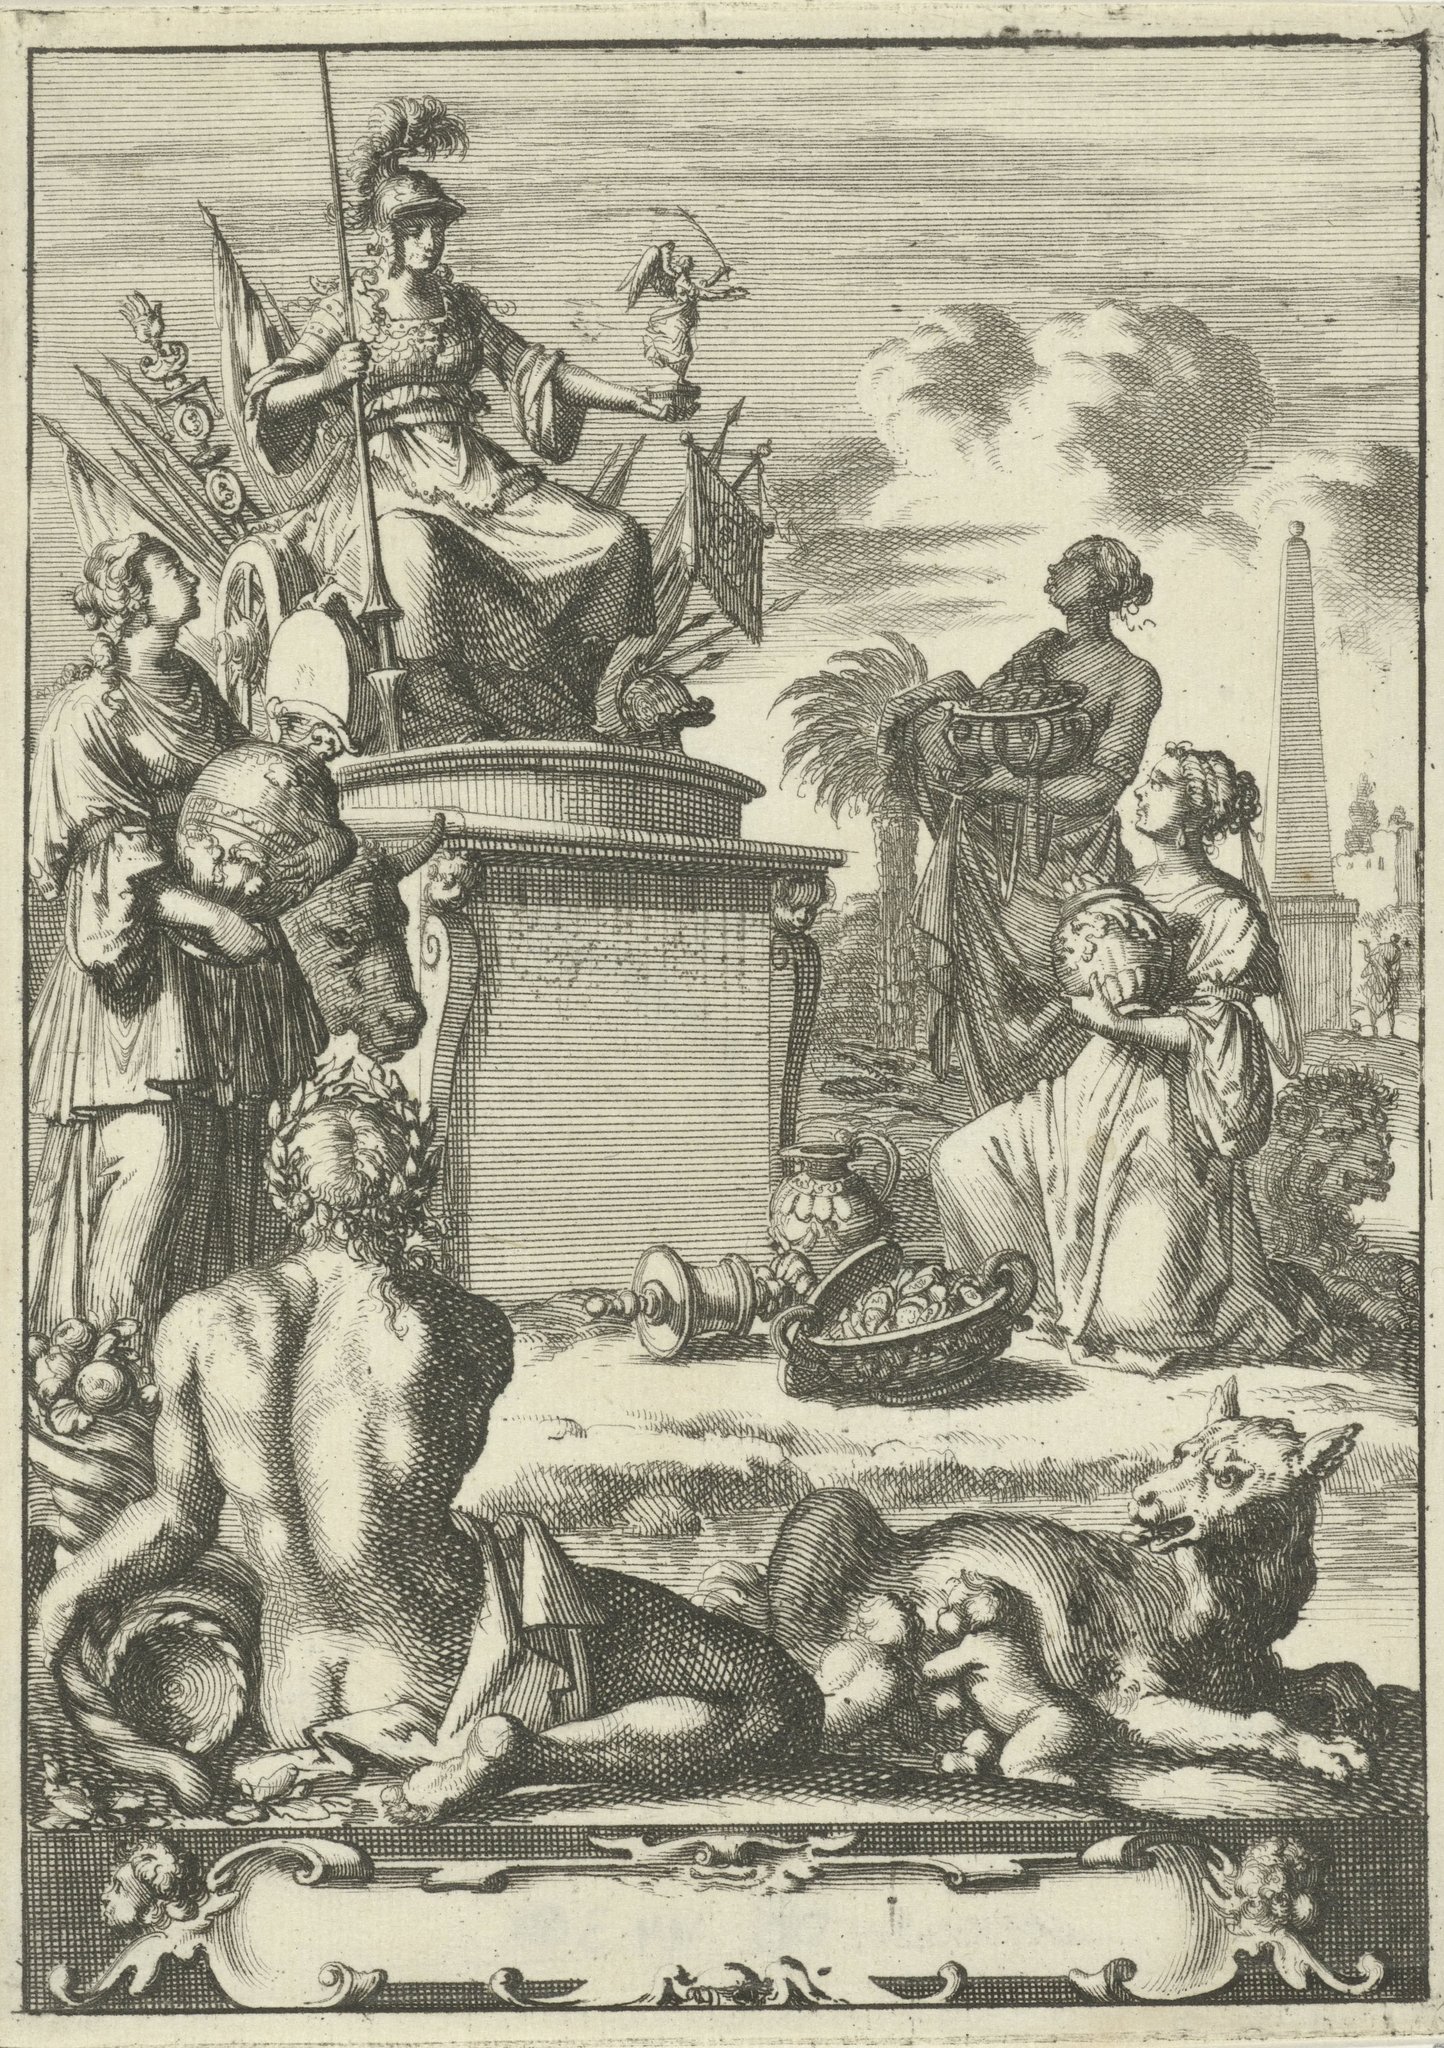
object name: print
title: Rome omringd door Europa, Afrika en Azië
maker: jan luyken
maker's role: draughtsman, print maker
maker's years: 1649-1712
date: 1690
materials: paper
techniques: etching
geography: amsterdam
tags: europe represented allegorically; 'europa' (ripa), asia represented allegorically; 'asia' (ripa), africa represented allegorically; 'africa' (ripa), personification of a city, town-patron(ess), romulus and remus are washed ashore and suckled by a she-wolf; 'lupa romana', river-gods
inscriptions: collector's mark: Lugt 2228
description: De personificatie van de stad Rome zit op een verhoging met een klein beeld van Victoria in haar handen. Rond haar staan de personificaties van Europa (met stier), Afrika (met krokodil) en Azië (met leeuw). Op de voorgrond liggen een riviergod, Romulus en Remus met de wolvin.